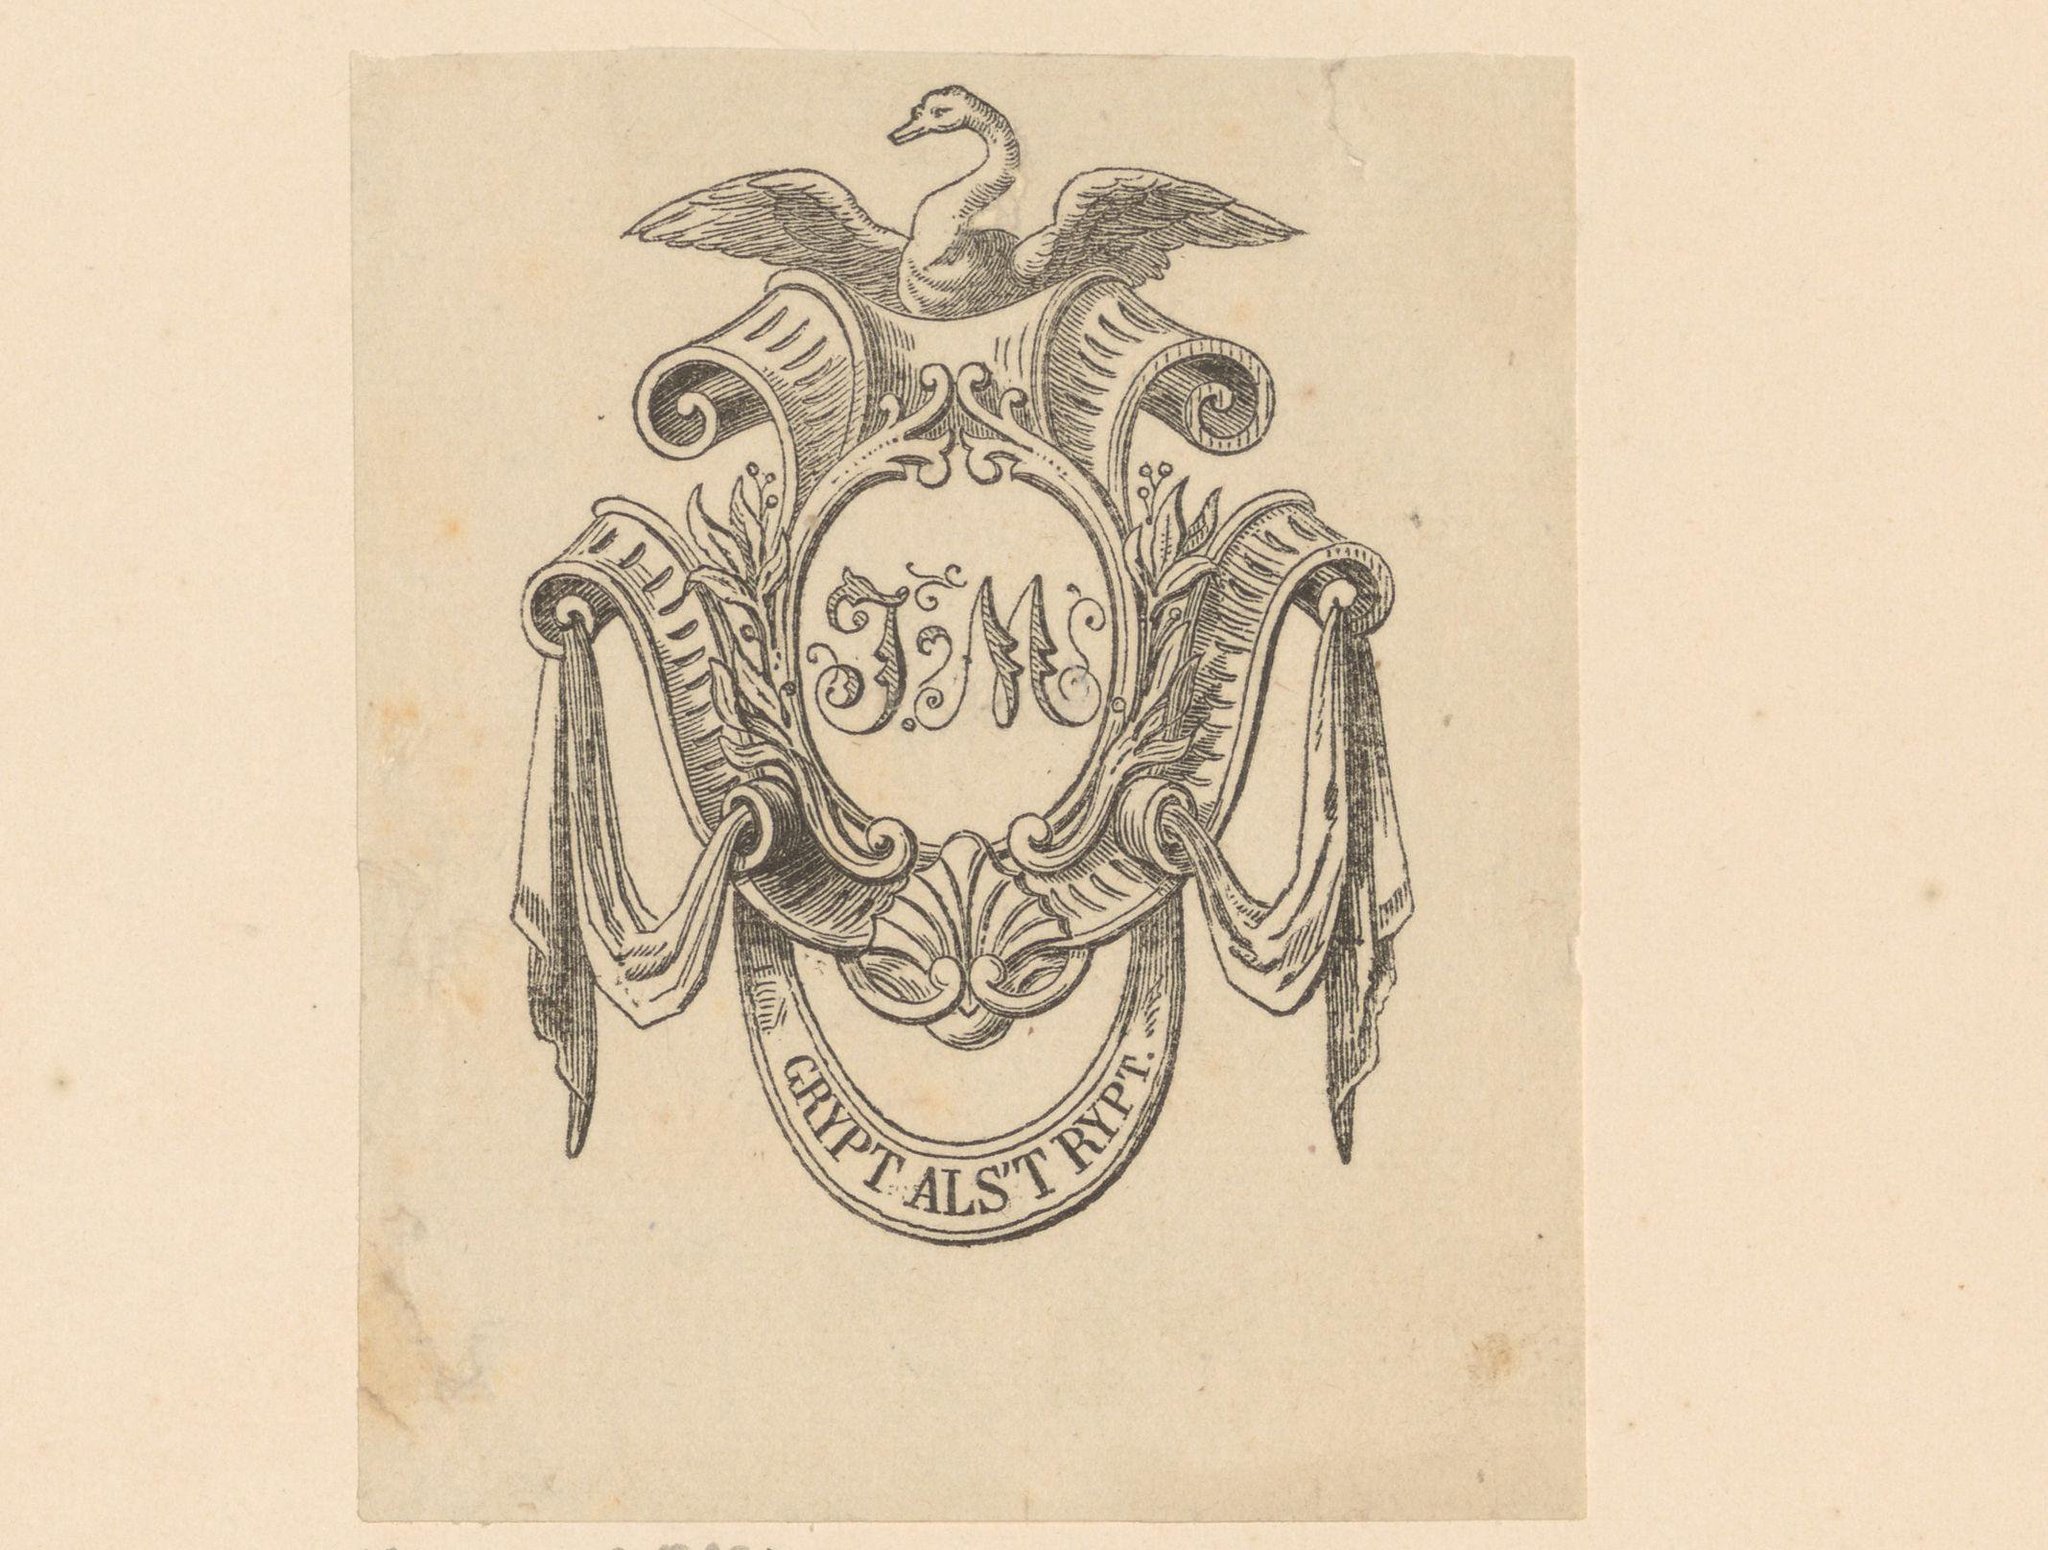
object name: bookplate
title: Ex libris van Isaac Meulman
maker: Anonymous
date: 1817-1868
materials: paper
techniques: printing block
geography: netherlands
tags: water-birds: swan, armorial bearing, heraldry